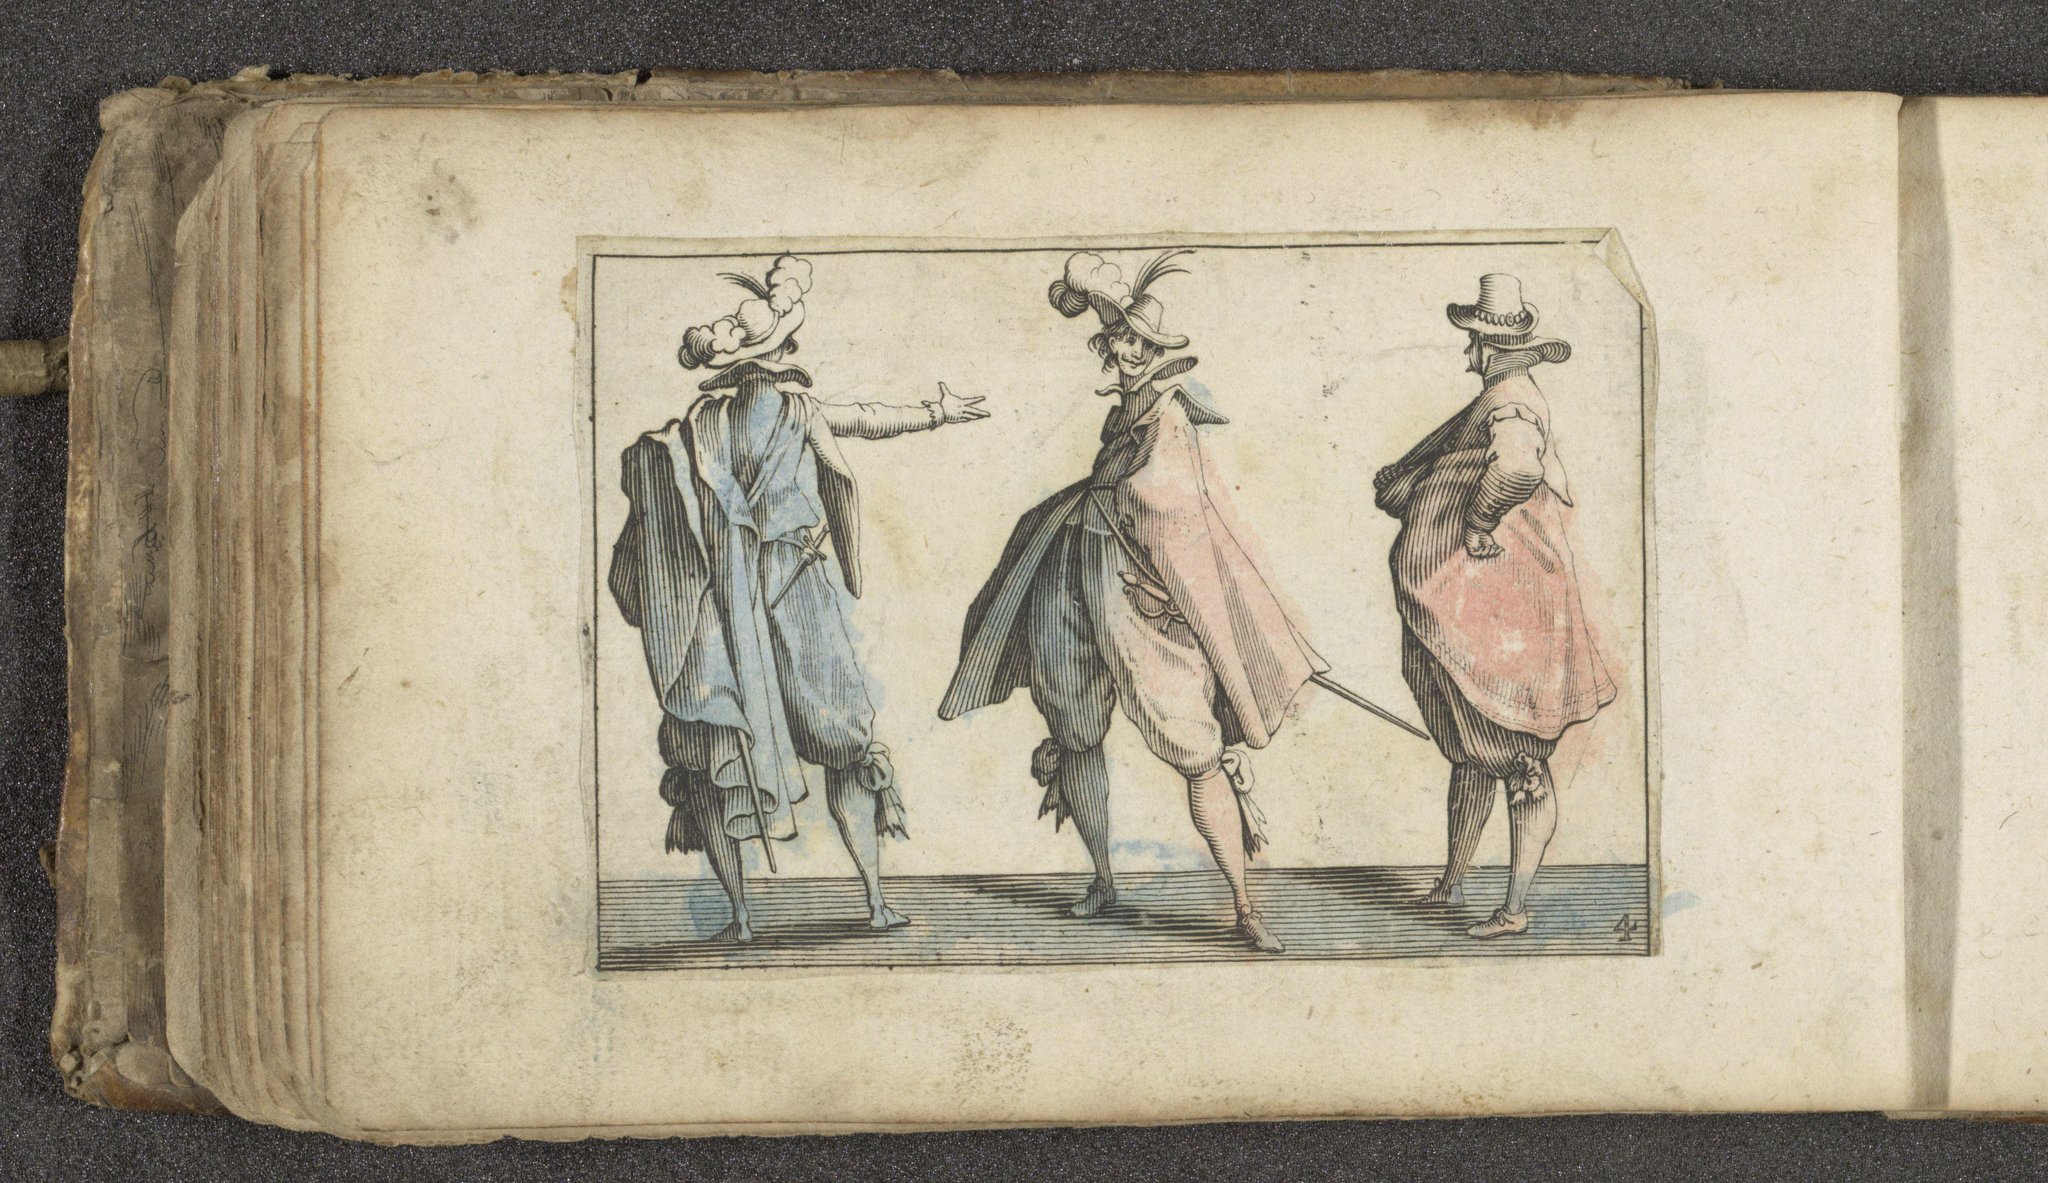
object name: album leaf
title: Drie acteurs met lange mantels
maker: paul göttich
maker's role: graveur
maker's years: 1586-1622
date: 1621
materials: paper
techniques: colour, engraving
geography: augsburg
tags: actor (on the stage), head-gear: hat (+ feathers used for clothes)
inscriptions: inscription: ‘51’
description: Drie staande heren of acteurs met lange mantels. Twee hebben een gepluimde hoed op hun hoofd. De prent maakt deel uit van een album.